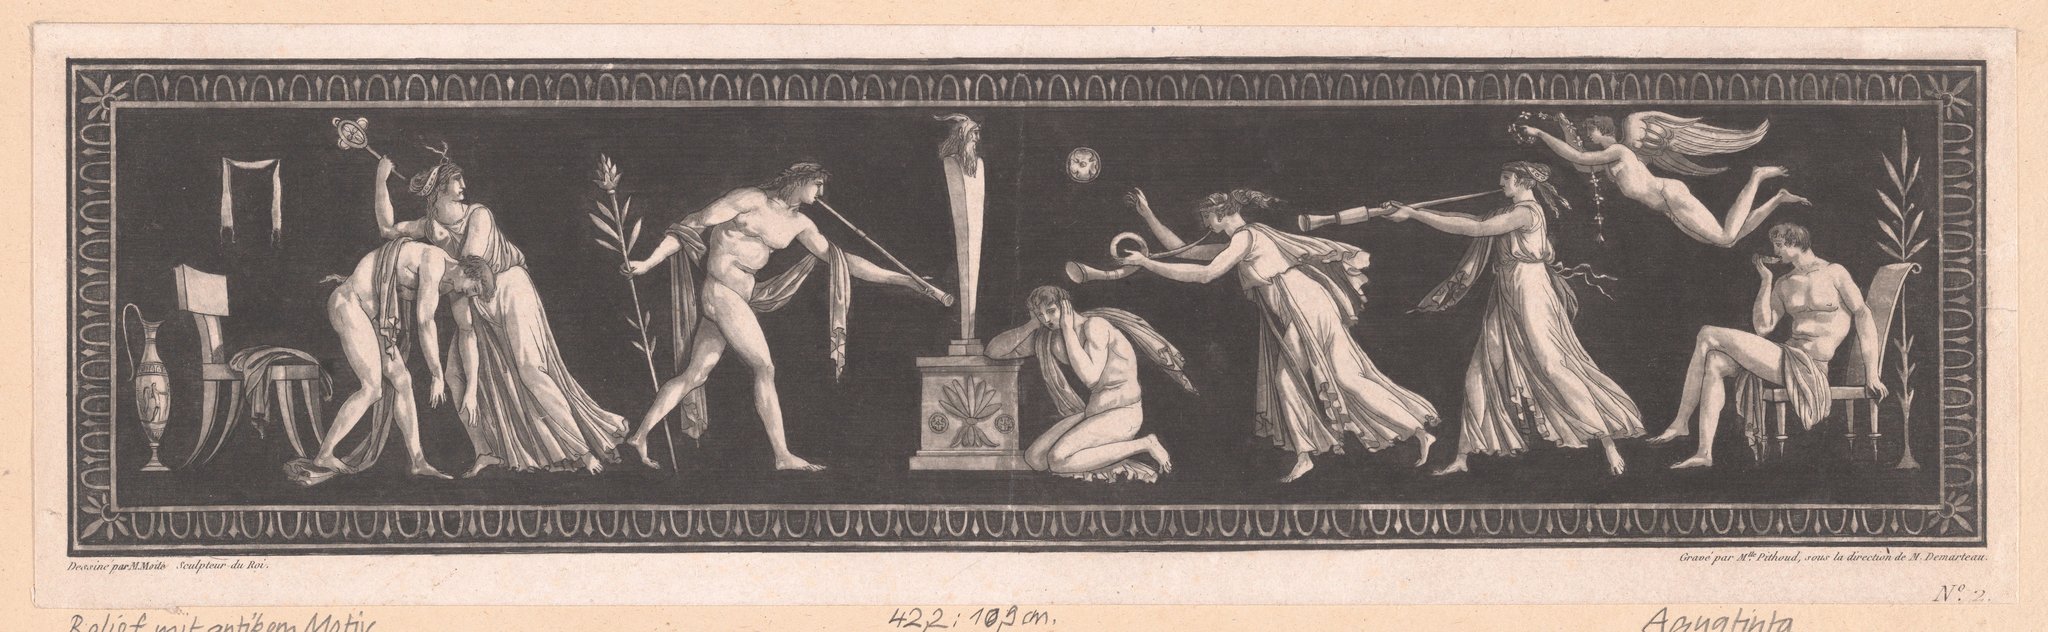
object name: print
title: Frieze with Antique Motifs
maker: louise pithoud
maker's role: artist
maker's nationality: french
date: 1791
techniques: aquatint, printmaking, engraving, etching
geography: germany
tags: musical instruments,men,women